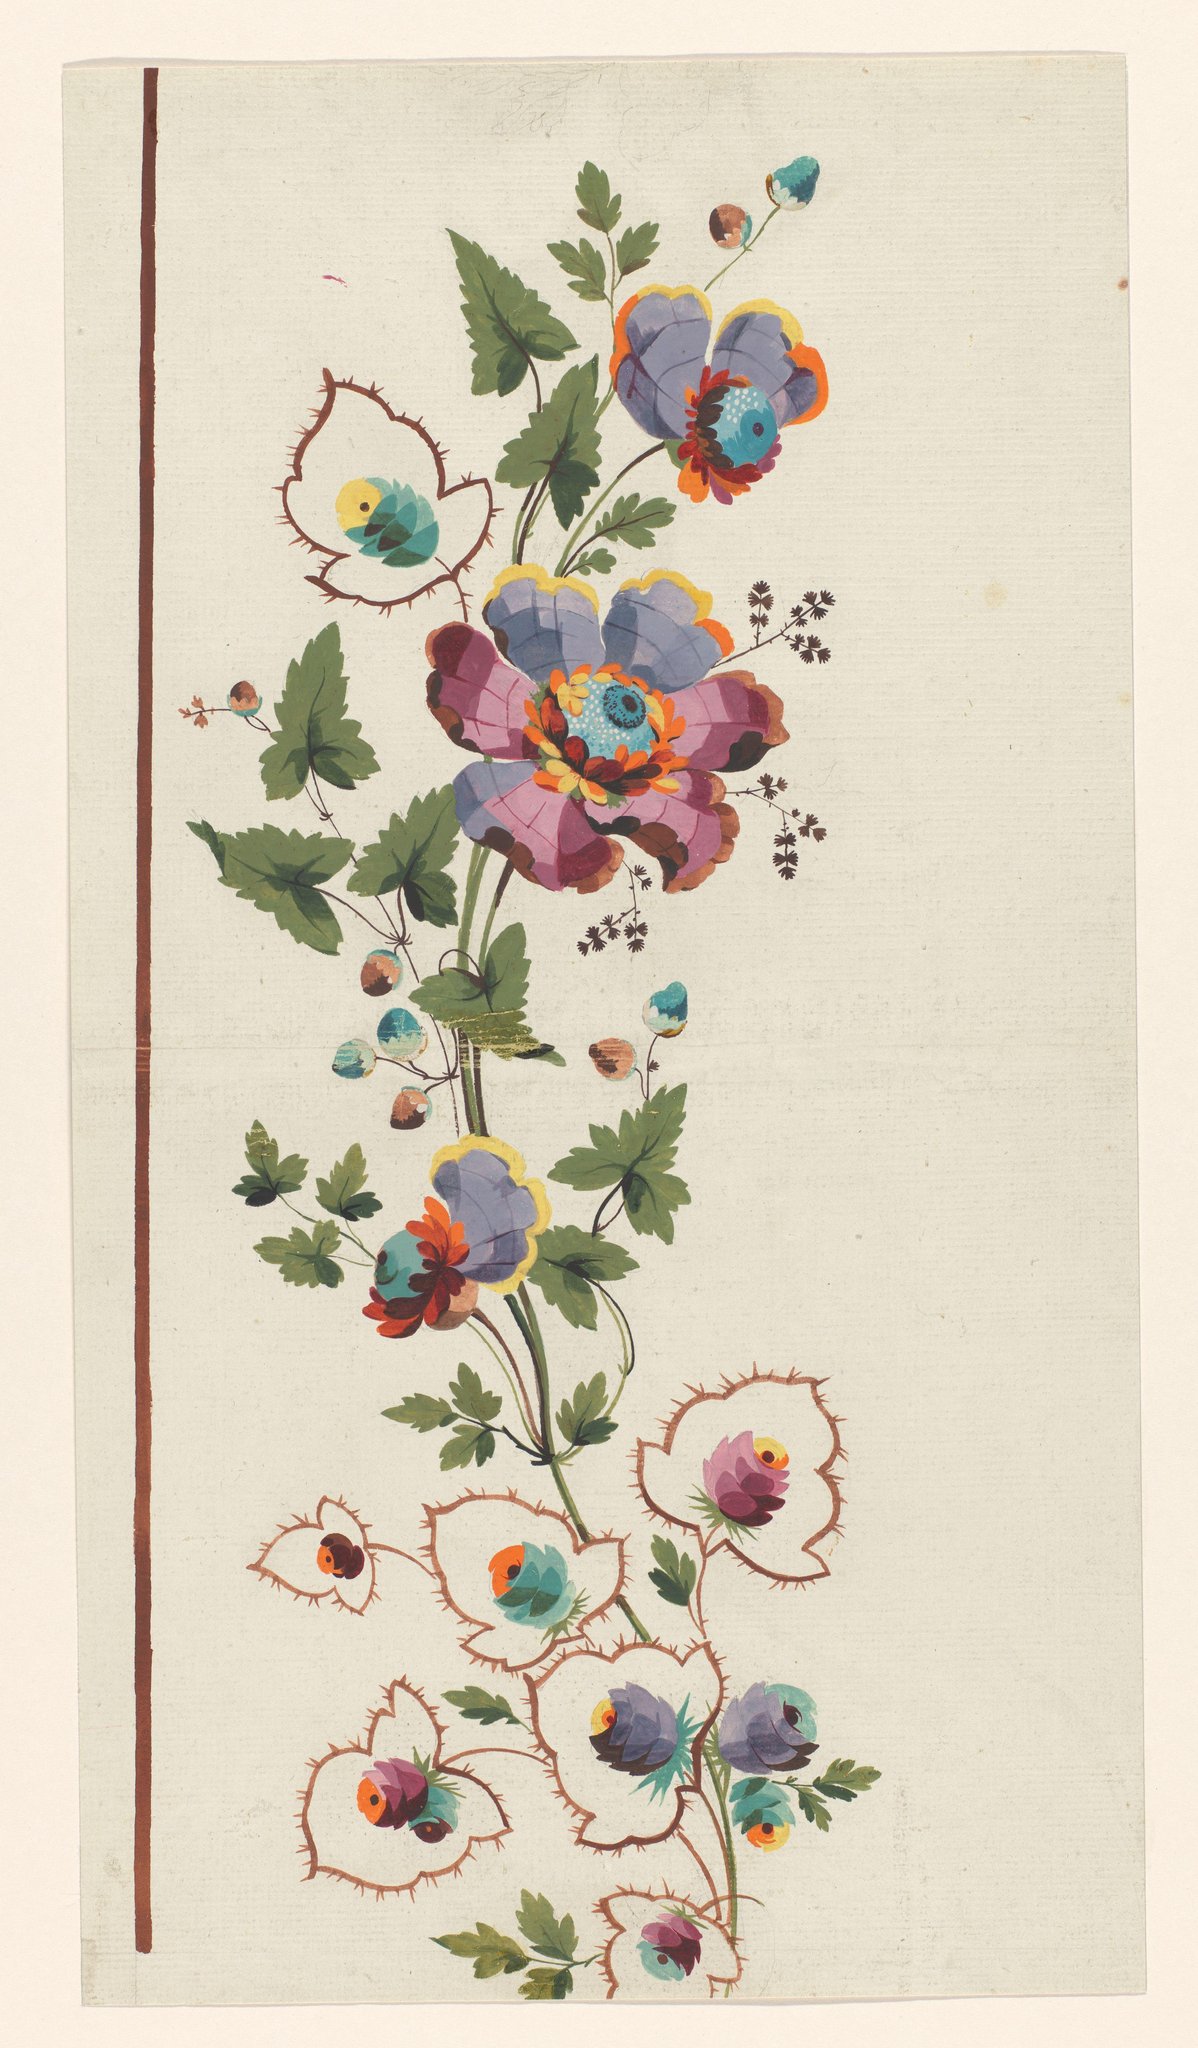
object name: design drawing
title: Ontwerp voor een geborduurde rand met bloemen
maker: Anonymous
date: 1780-1800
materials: gouache, graphite, paper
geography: france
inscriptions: watermark: ‘Mav[..]go[..]ier / HA[…]’, inscription: ‘NoncageL [?]’